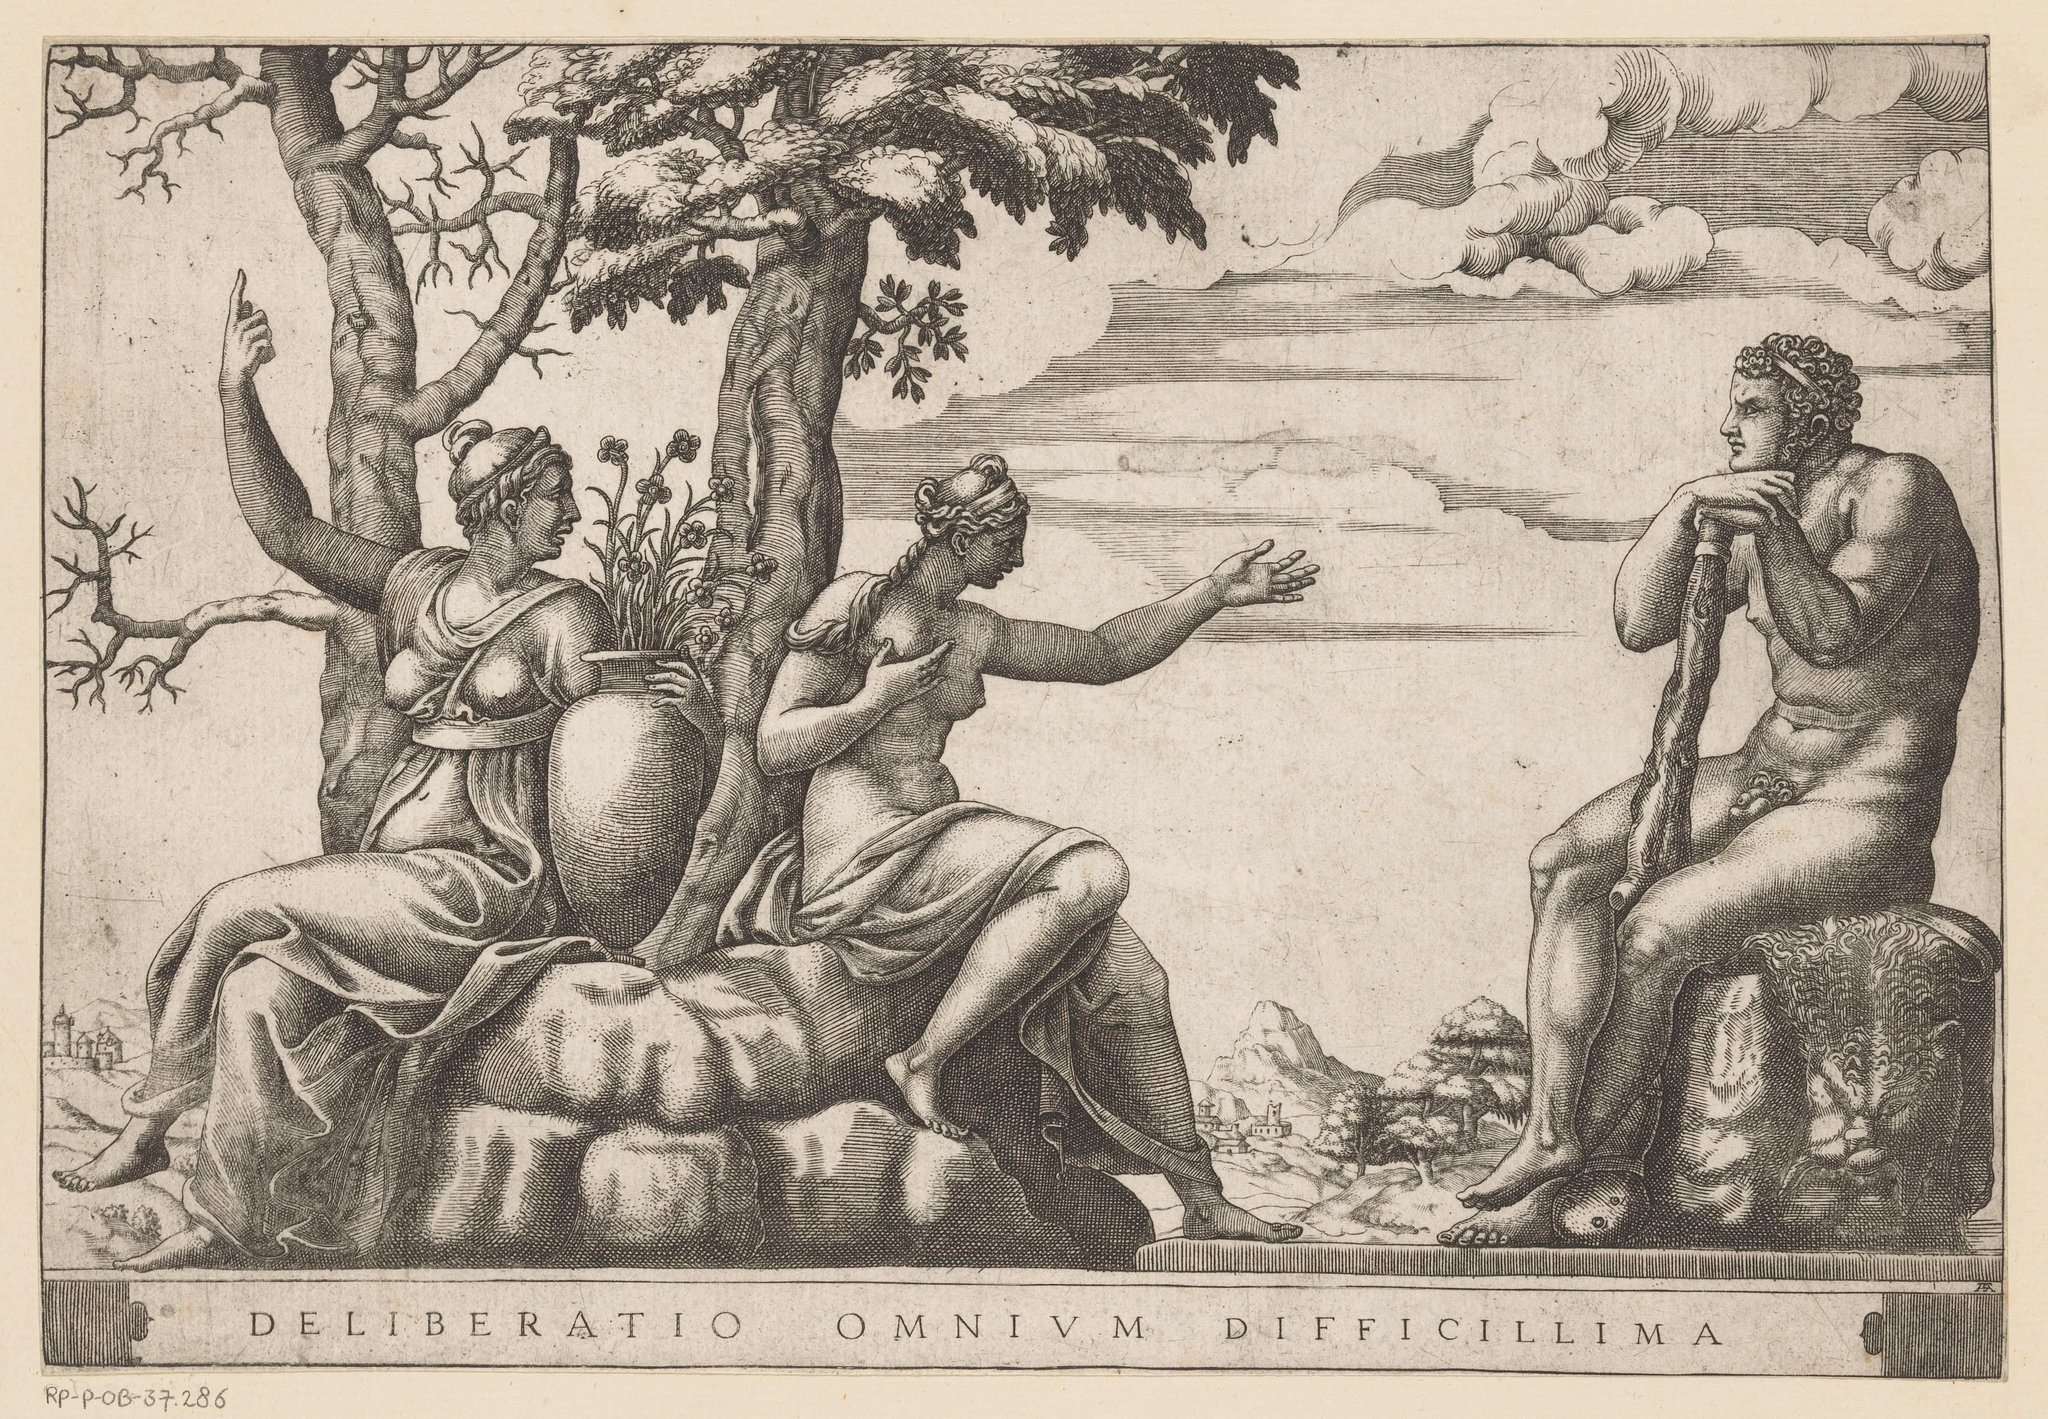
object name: print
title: Deliberatio omnium difficillima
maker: adamo scultori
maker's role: painter, print maker, sculptor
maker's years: 1530-1585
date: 1540-1585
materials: paper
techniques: engraving, intaglio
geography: italy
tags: hercules at the cross-roads, 'herkules am scheidewege': the choice of hercules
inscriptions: collector's mark: Lugt 240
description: Op de tweesprong moet Hercules kiezen tussen twee vrouwenfiguren, de gepersonifieerde Deugd en Ondeugd. Hercules zit rechts op zijn leeuwenhuid, leunend op zijn knots. Links zitten de vrouwelijke personificaties: Deugd is gekleed en slaat haar arm om een vaas met bloemen en Ondeugd is naakt. Titel in ondermarge.